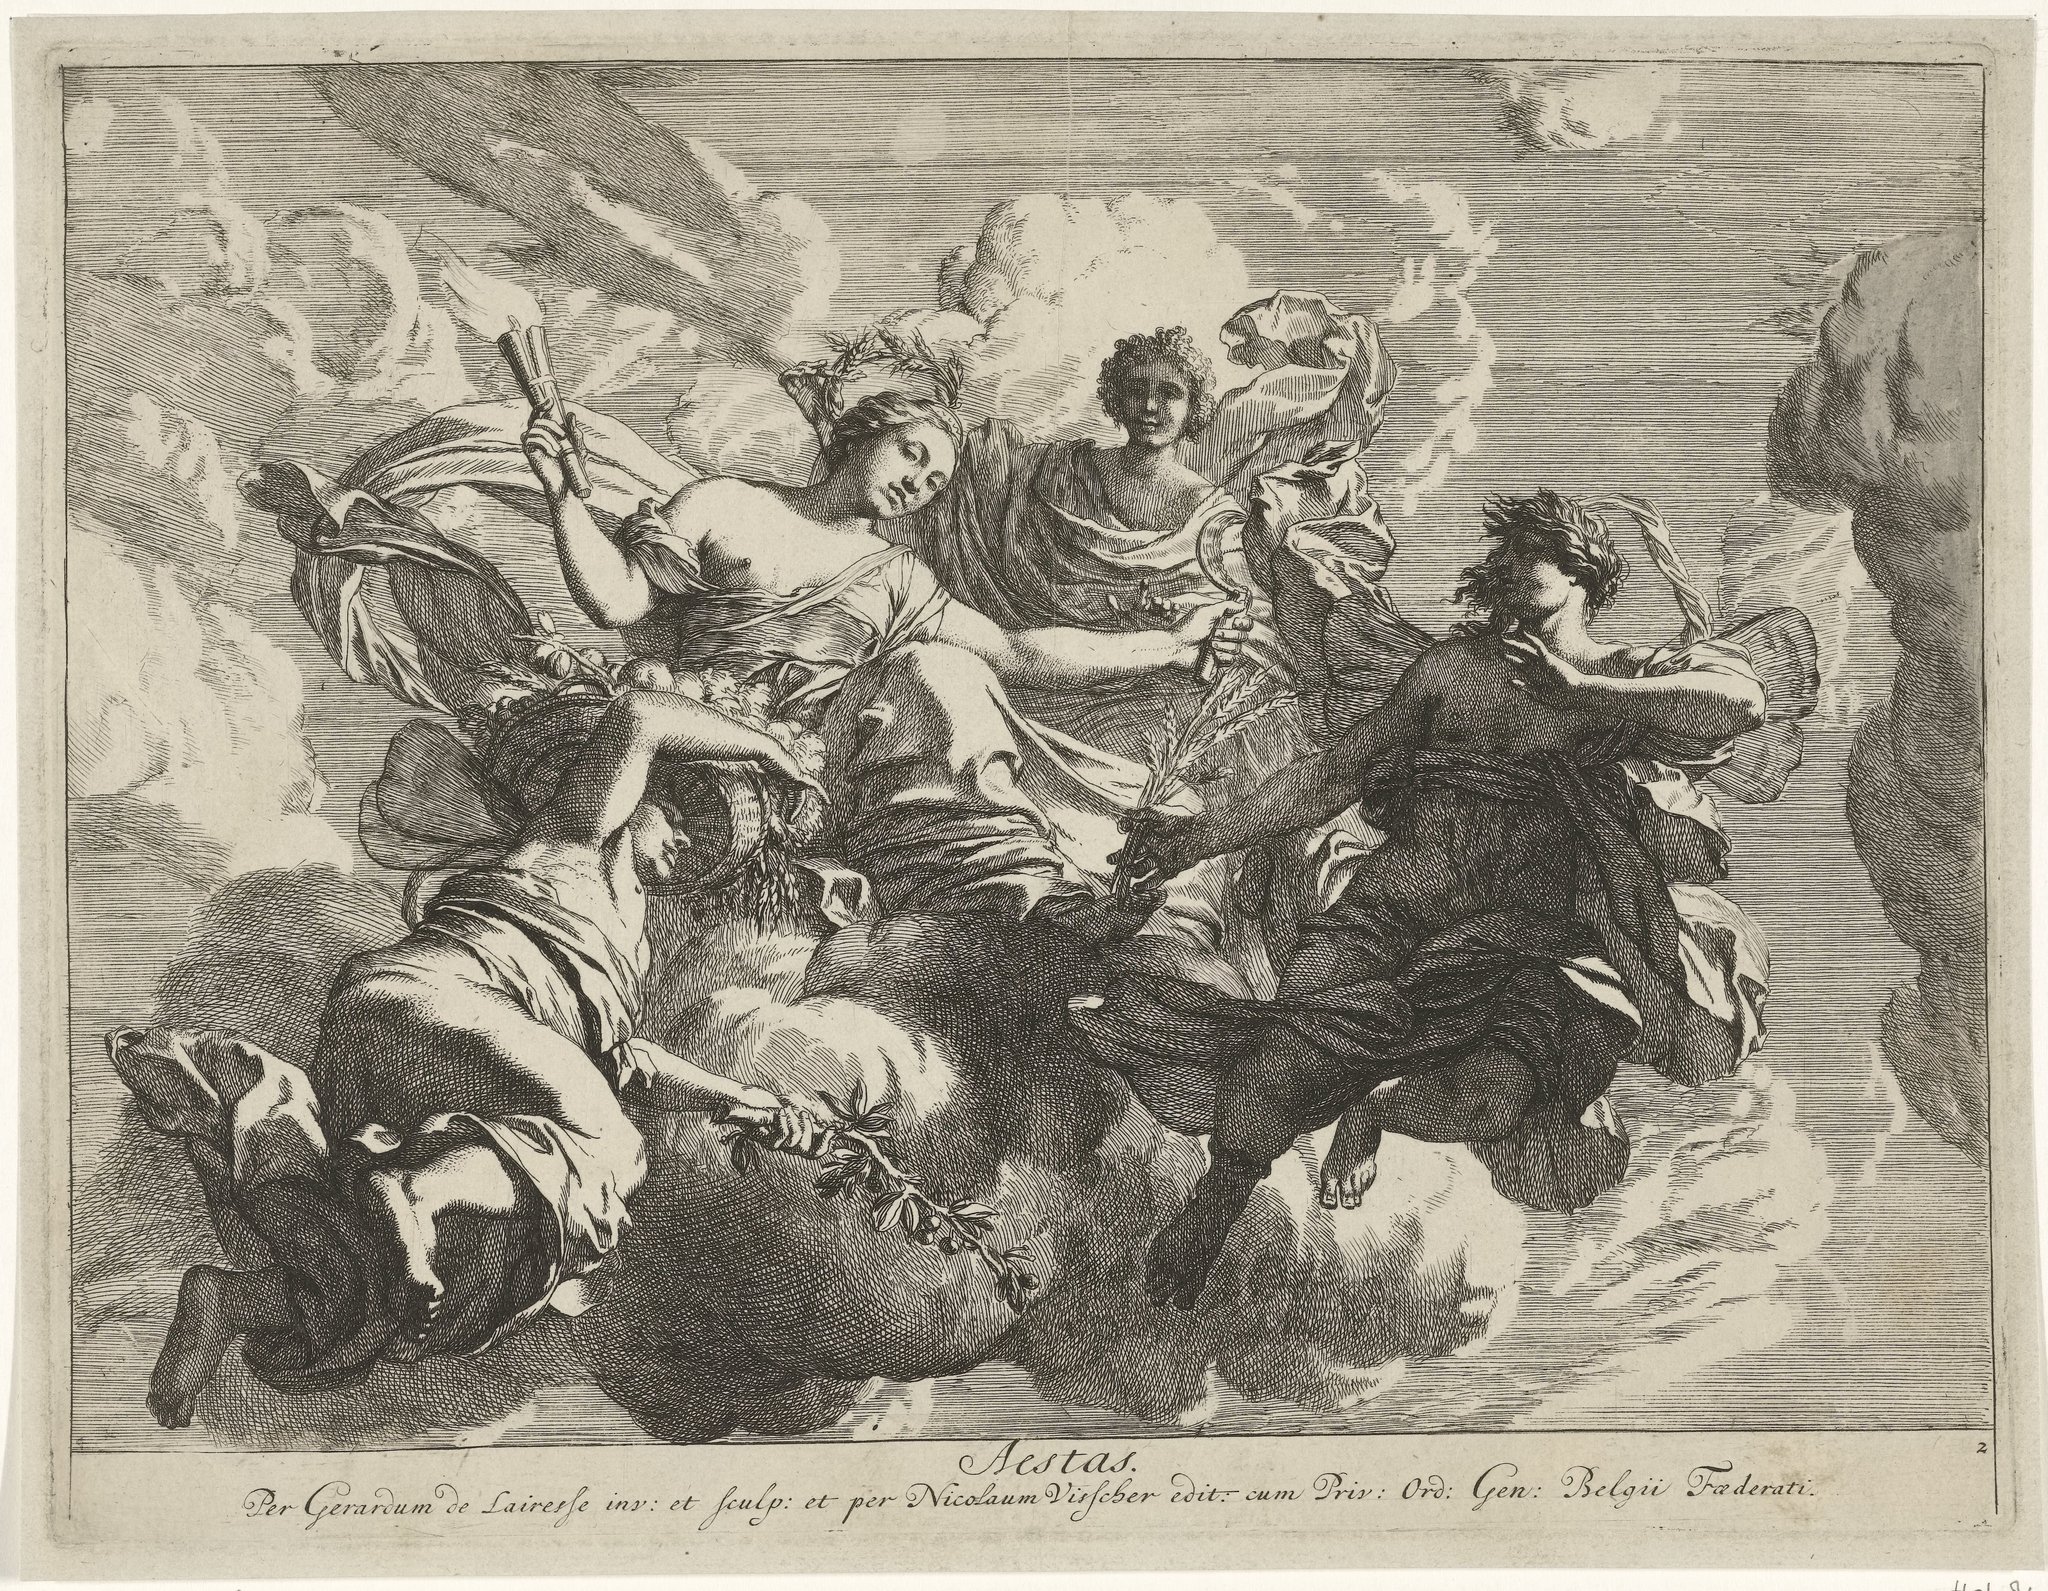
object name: print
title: Zomer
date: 1675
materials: paper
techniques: etching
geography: amsterdam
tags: (story of) ceres (demeter), summer, 'aestas'; 'estate' (ripa)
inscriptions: collector's mark: Lugt 2228, collector's mark: Lugt 237a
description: Ceres zit als personificatie van de zomer op een wolk en is omgeven door drie gepersonifieerde maanden die fruitmanden, olijftakken en graan aandragen. Ceres wordt gekroond met een krans van graan, in haar handen houdt ze een brandende toorts en een sikkel. De prent maakt deel uit van een vierdelige serie prenten over de vier jaargetijden.